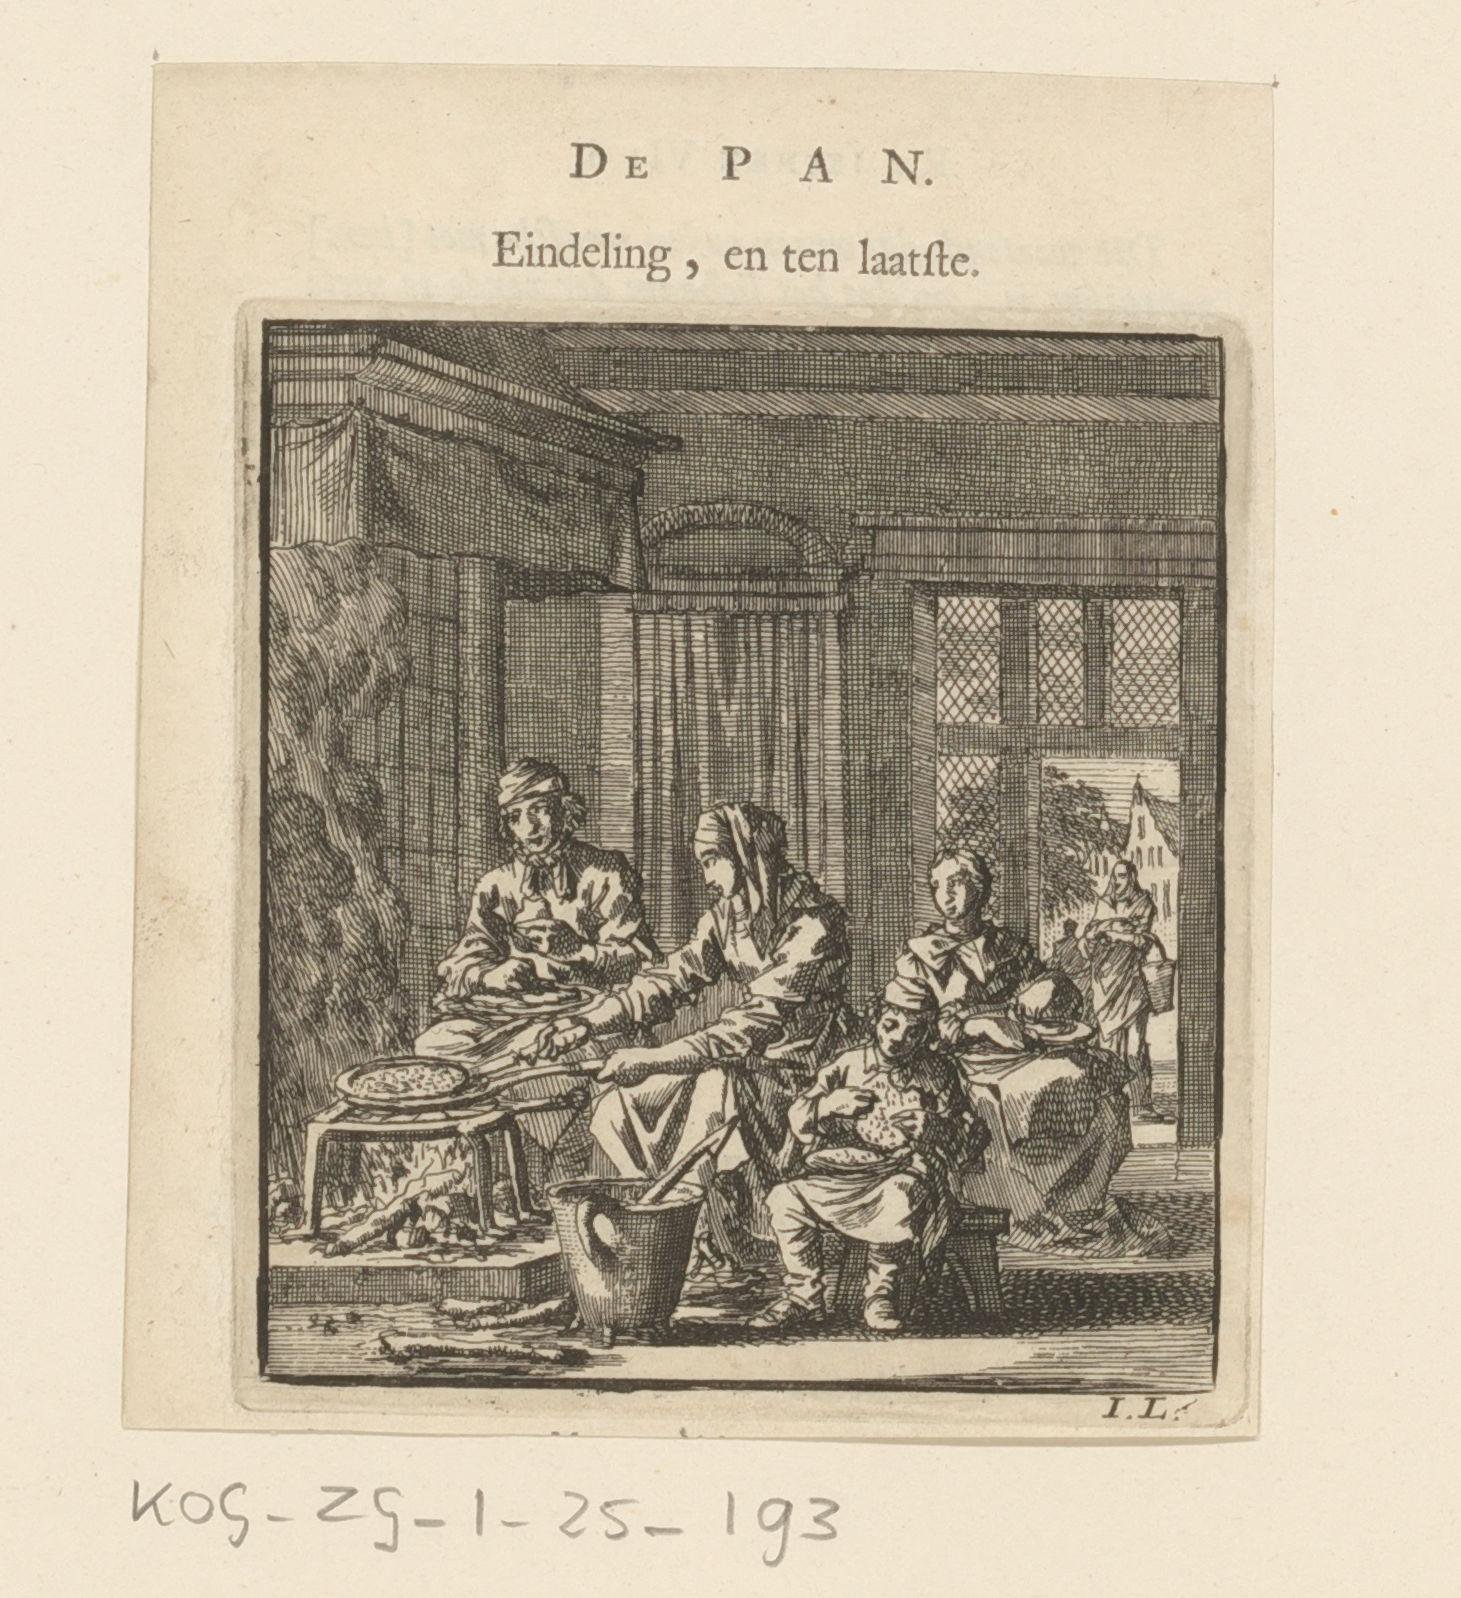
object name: print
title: Pannenkoekenbakster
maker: jan luyken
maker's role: draughtsman, print maker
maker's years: 1649-1712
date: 1711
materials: paper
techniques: etching, letterpress printing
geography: amsterdam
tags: pancakes, cooking food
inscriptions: collector's mark: Lugt 1641, stamp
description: Prent uit: Luyken, Jan. Het leerzaam huisraad, vertoond in vyftig konstige figuuren, met godlyke spreuken en stichtelyke verzen. Amsterdam: weduwe Pieter Arentsz. II en Cornelis van der Sys, 1711, p. 126.